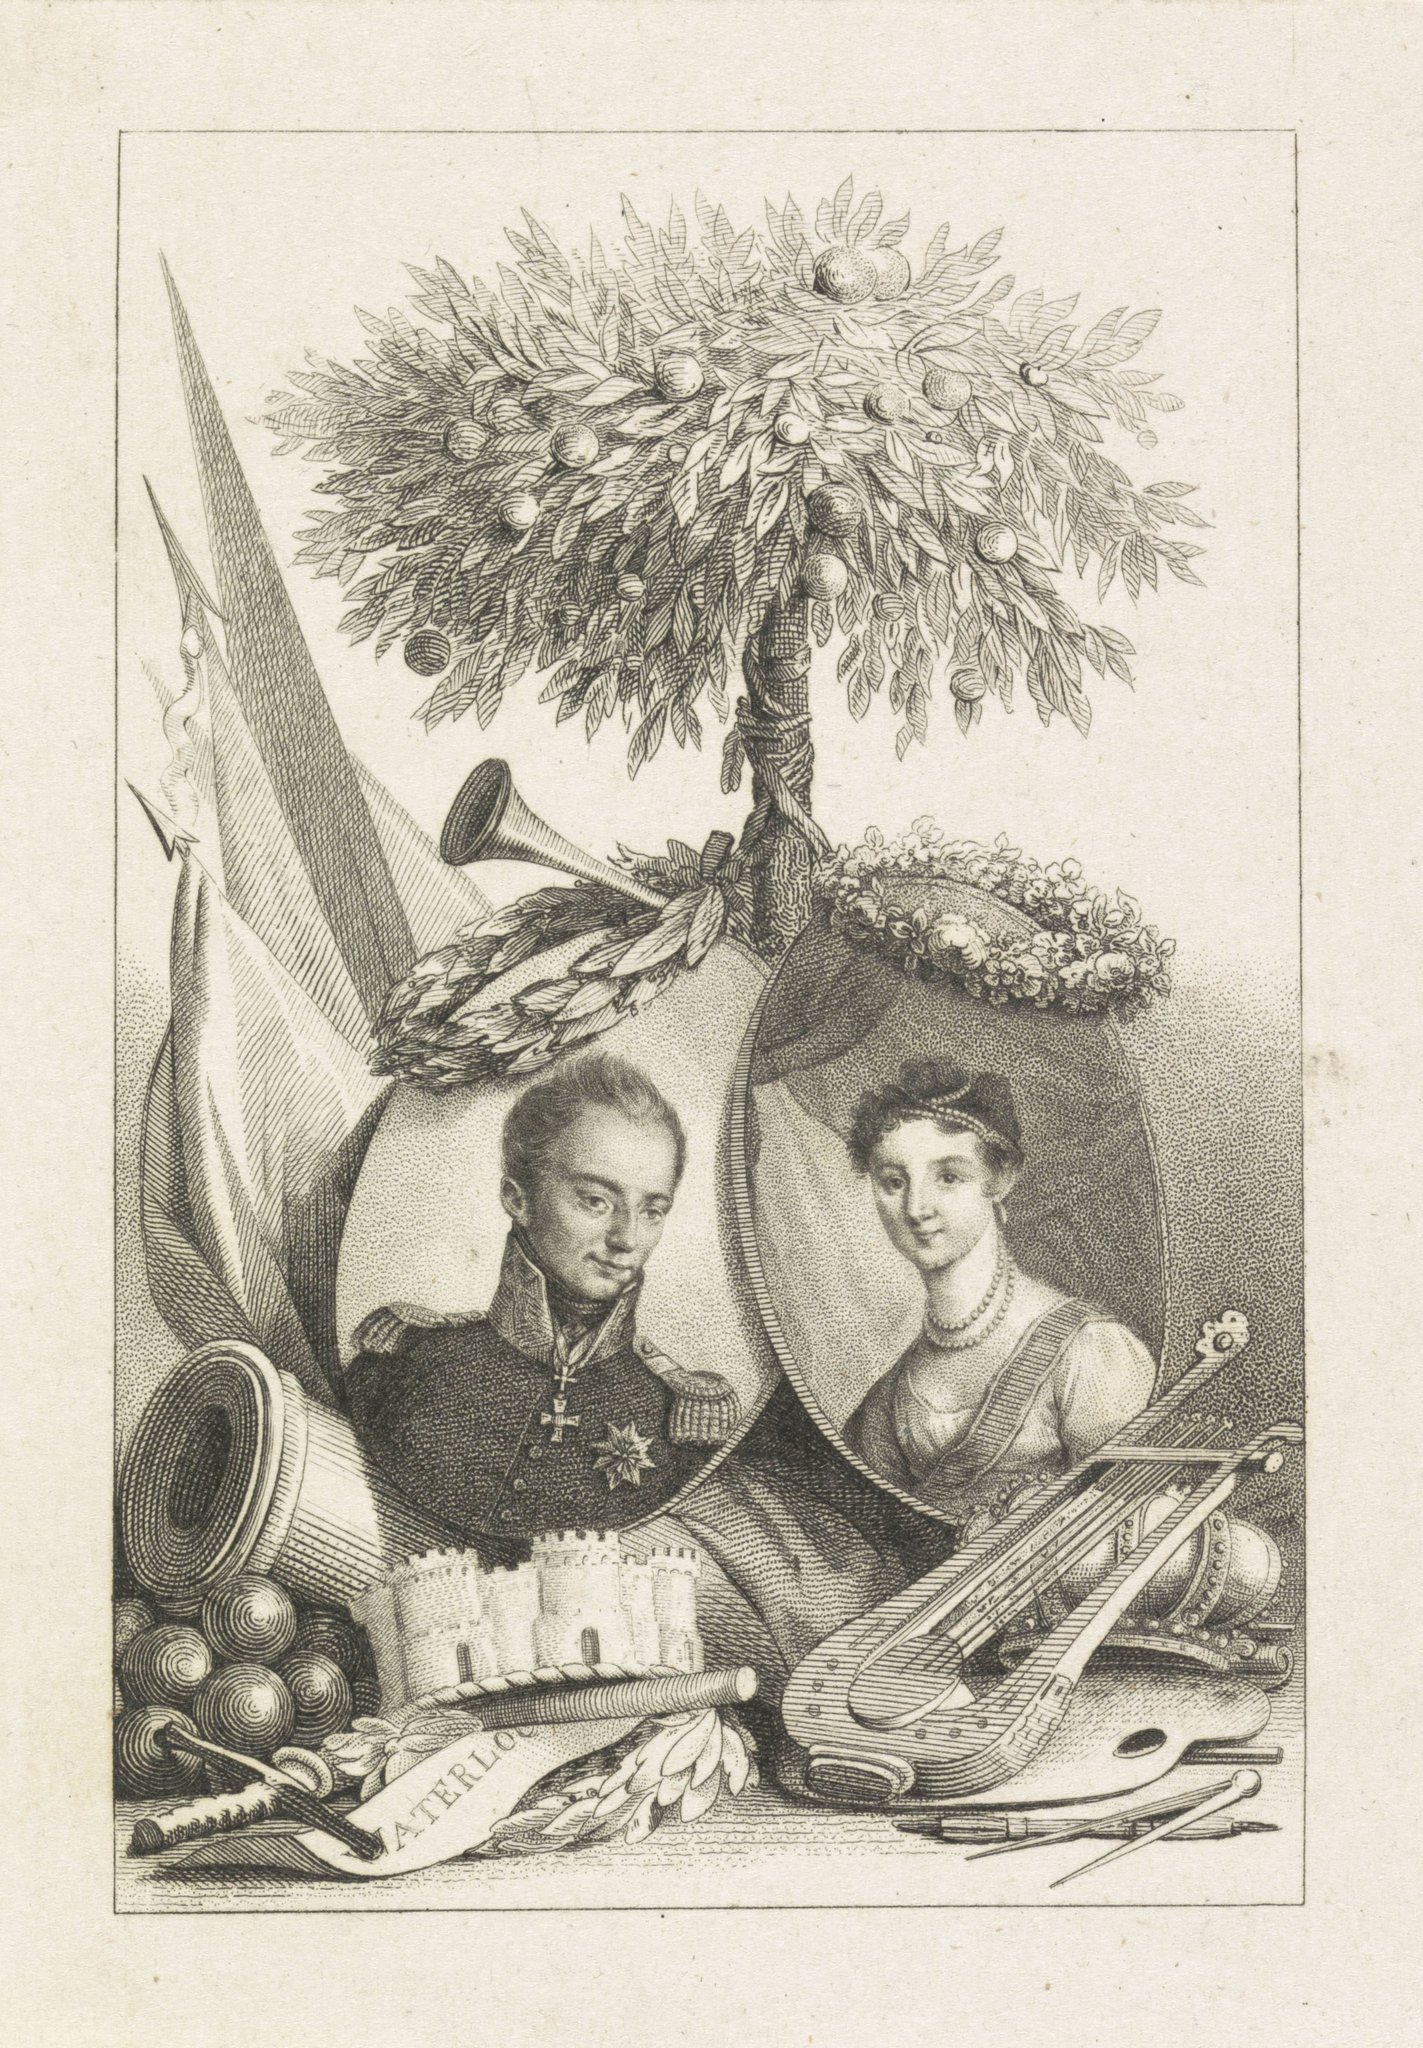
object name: print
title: Huwelijk van de prins van Oranje en Anna Paulowna, 1816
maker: Anonymous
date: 1816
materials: paper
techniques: etching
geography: netherlands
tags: anna paulowna romanowa, the hague, william ii of the netherlands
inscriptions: collector's mark: Lugt 2228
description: Huwelijk van de prins van Oranje en Anna Paulowna, 21 februari 1816. Twee medaillons met portretten van het echtpaar gebonden aan een Oranjeboom. Op de voorgrond attributen van de oorlog en de slag bij Waterloo bij de prins; bij de prinses een lier, schilderspalet en een keizerskroon.